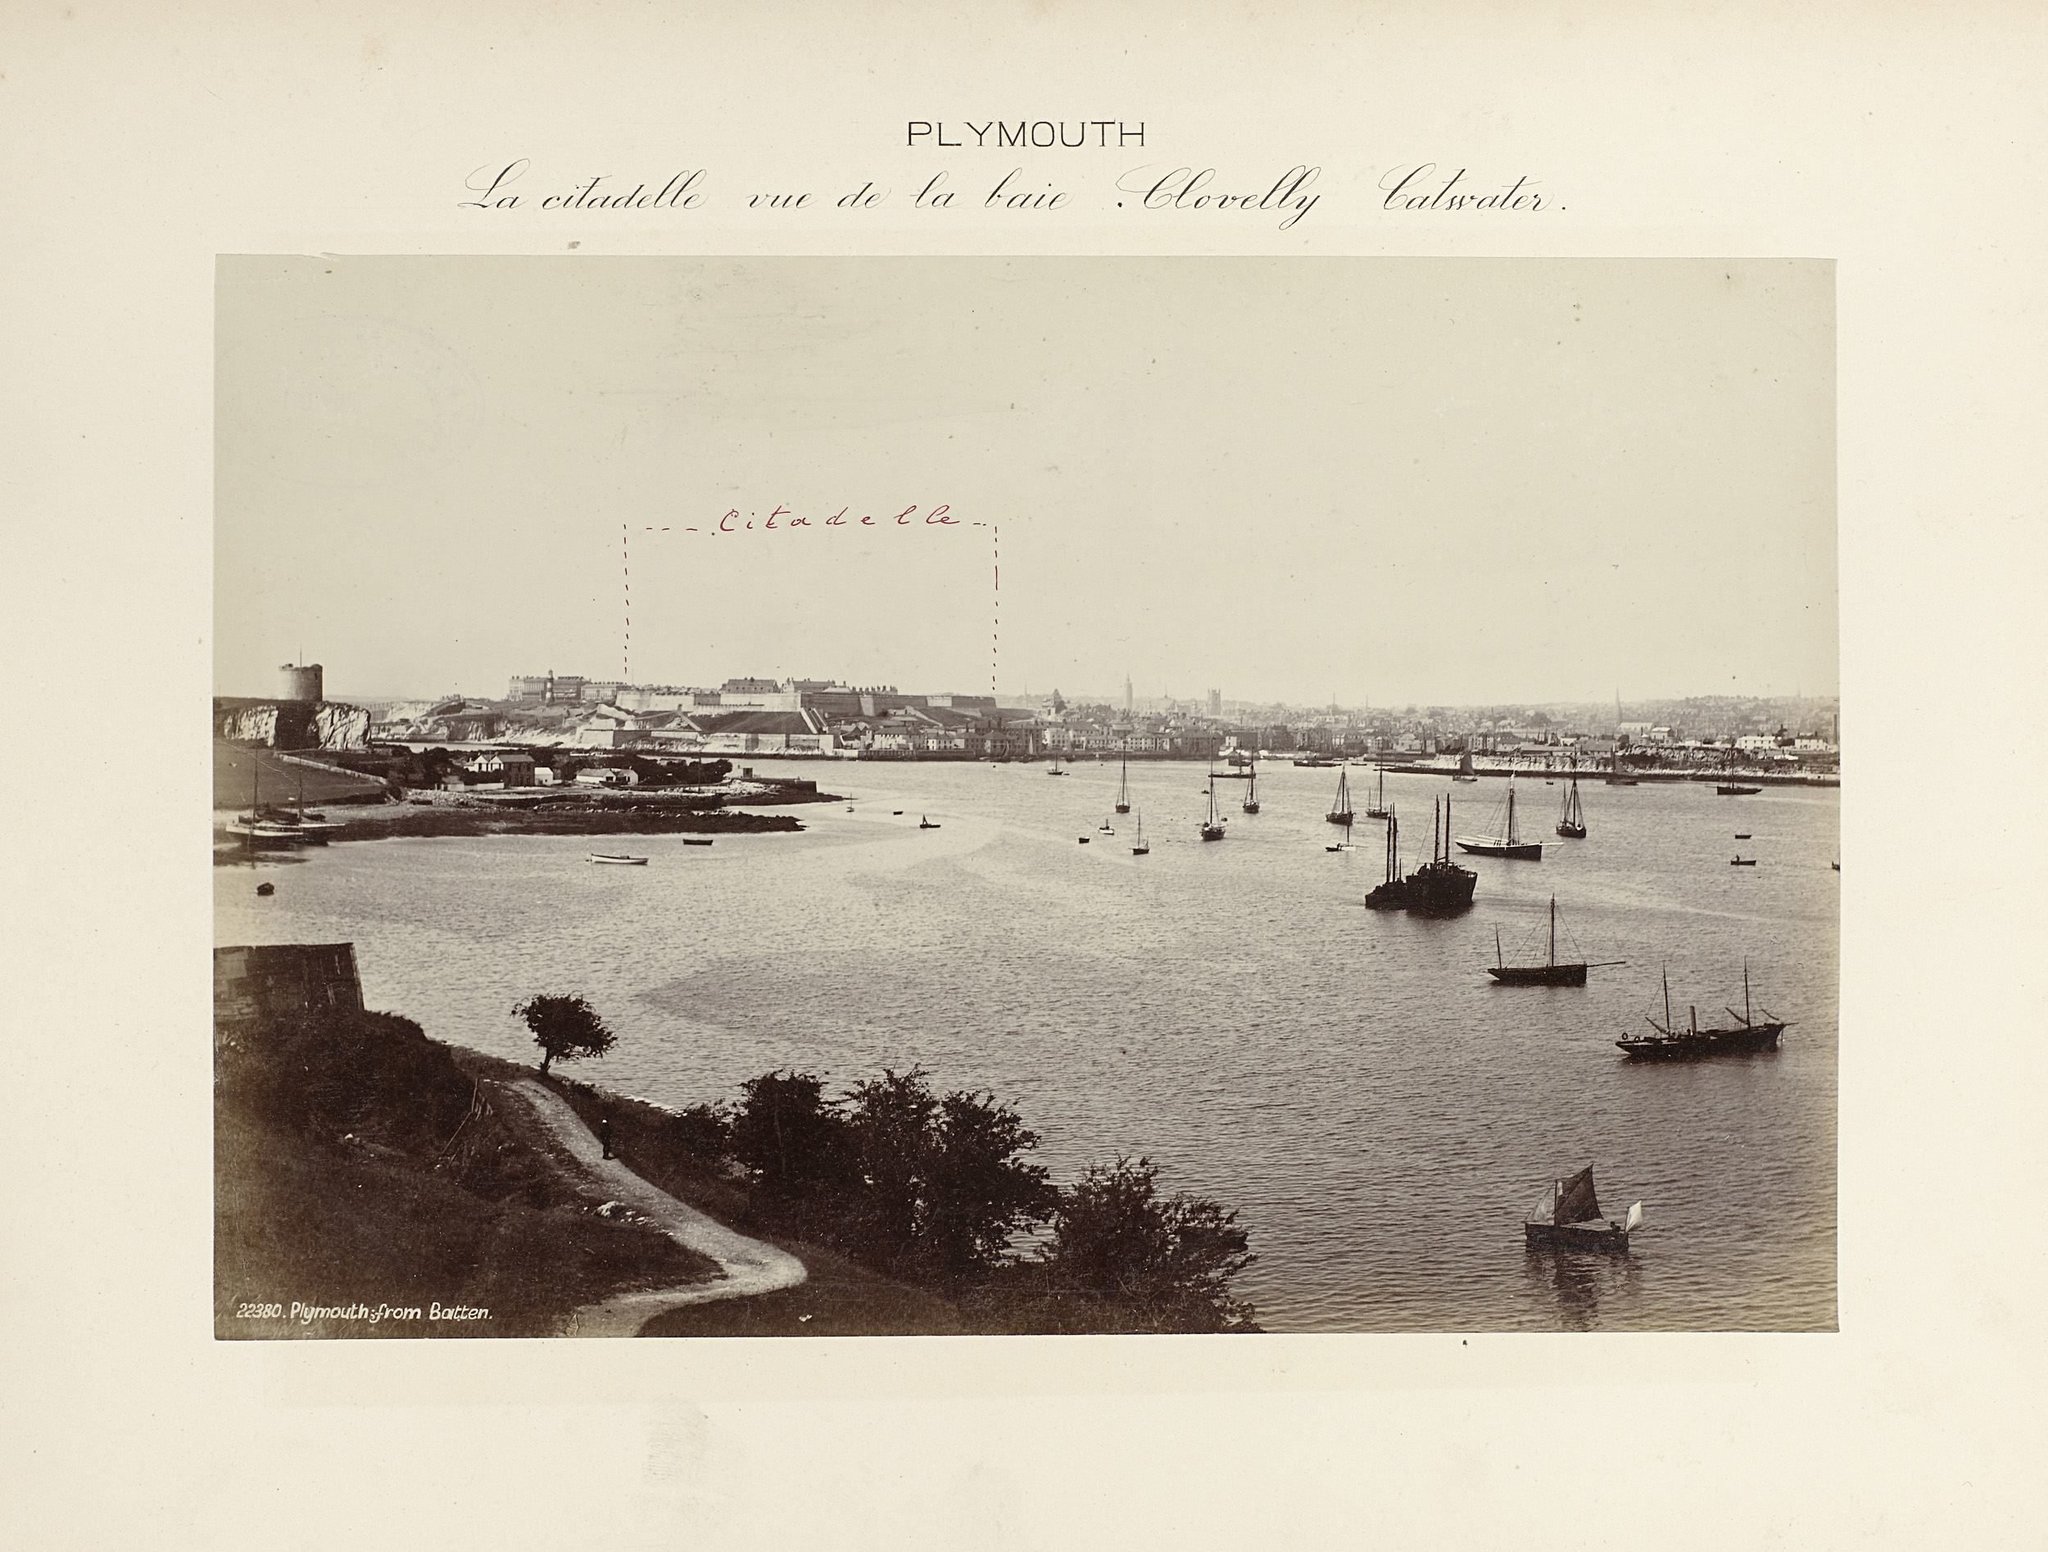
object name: photograph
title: Angleterre. Défense des côtes. Reconaissance de 1891. Photographies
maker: Anonymous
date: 1891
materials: cardboard, paper, photographic support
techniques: albumen print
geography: great britain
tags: plymouth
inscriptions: inscription: ‘Citadelle’, inscription: ‘PLYMOUTH / La citadelle vue de la baie. Clovelly Catswater.’, inscription: ‘22380. Plymouth: from Batten’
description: Foto uit een album met 35 topografische foto's van Britse kustplaatsen, waarop in pen militaire verdedigingswerken zijn aangegeven door een Franse militair.